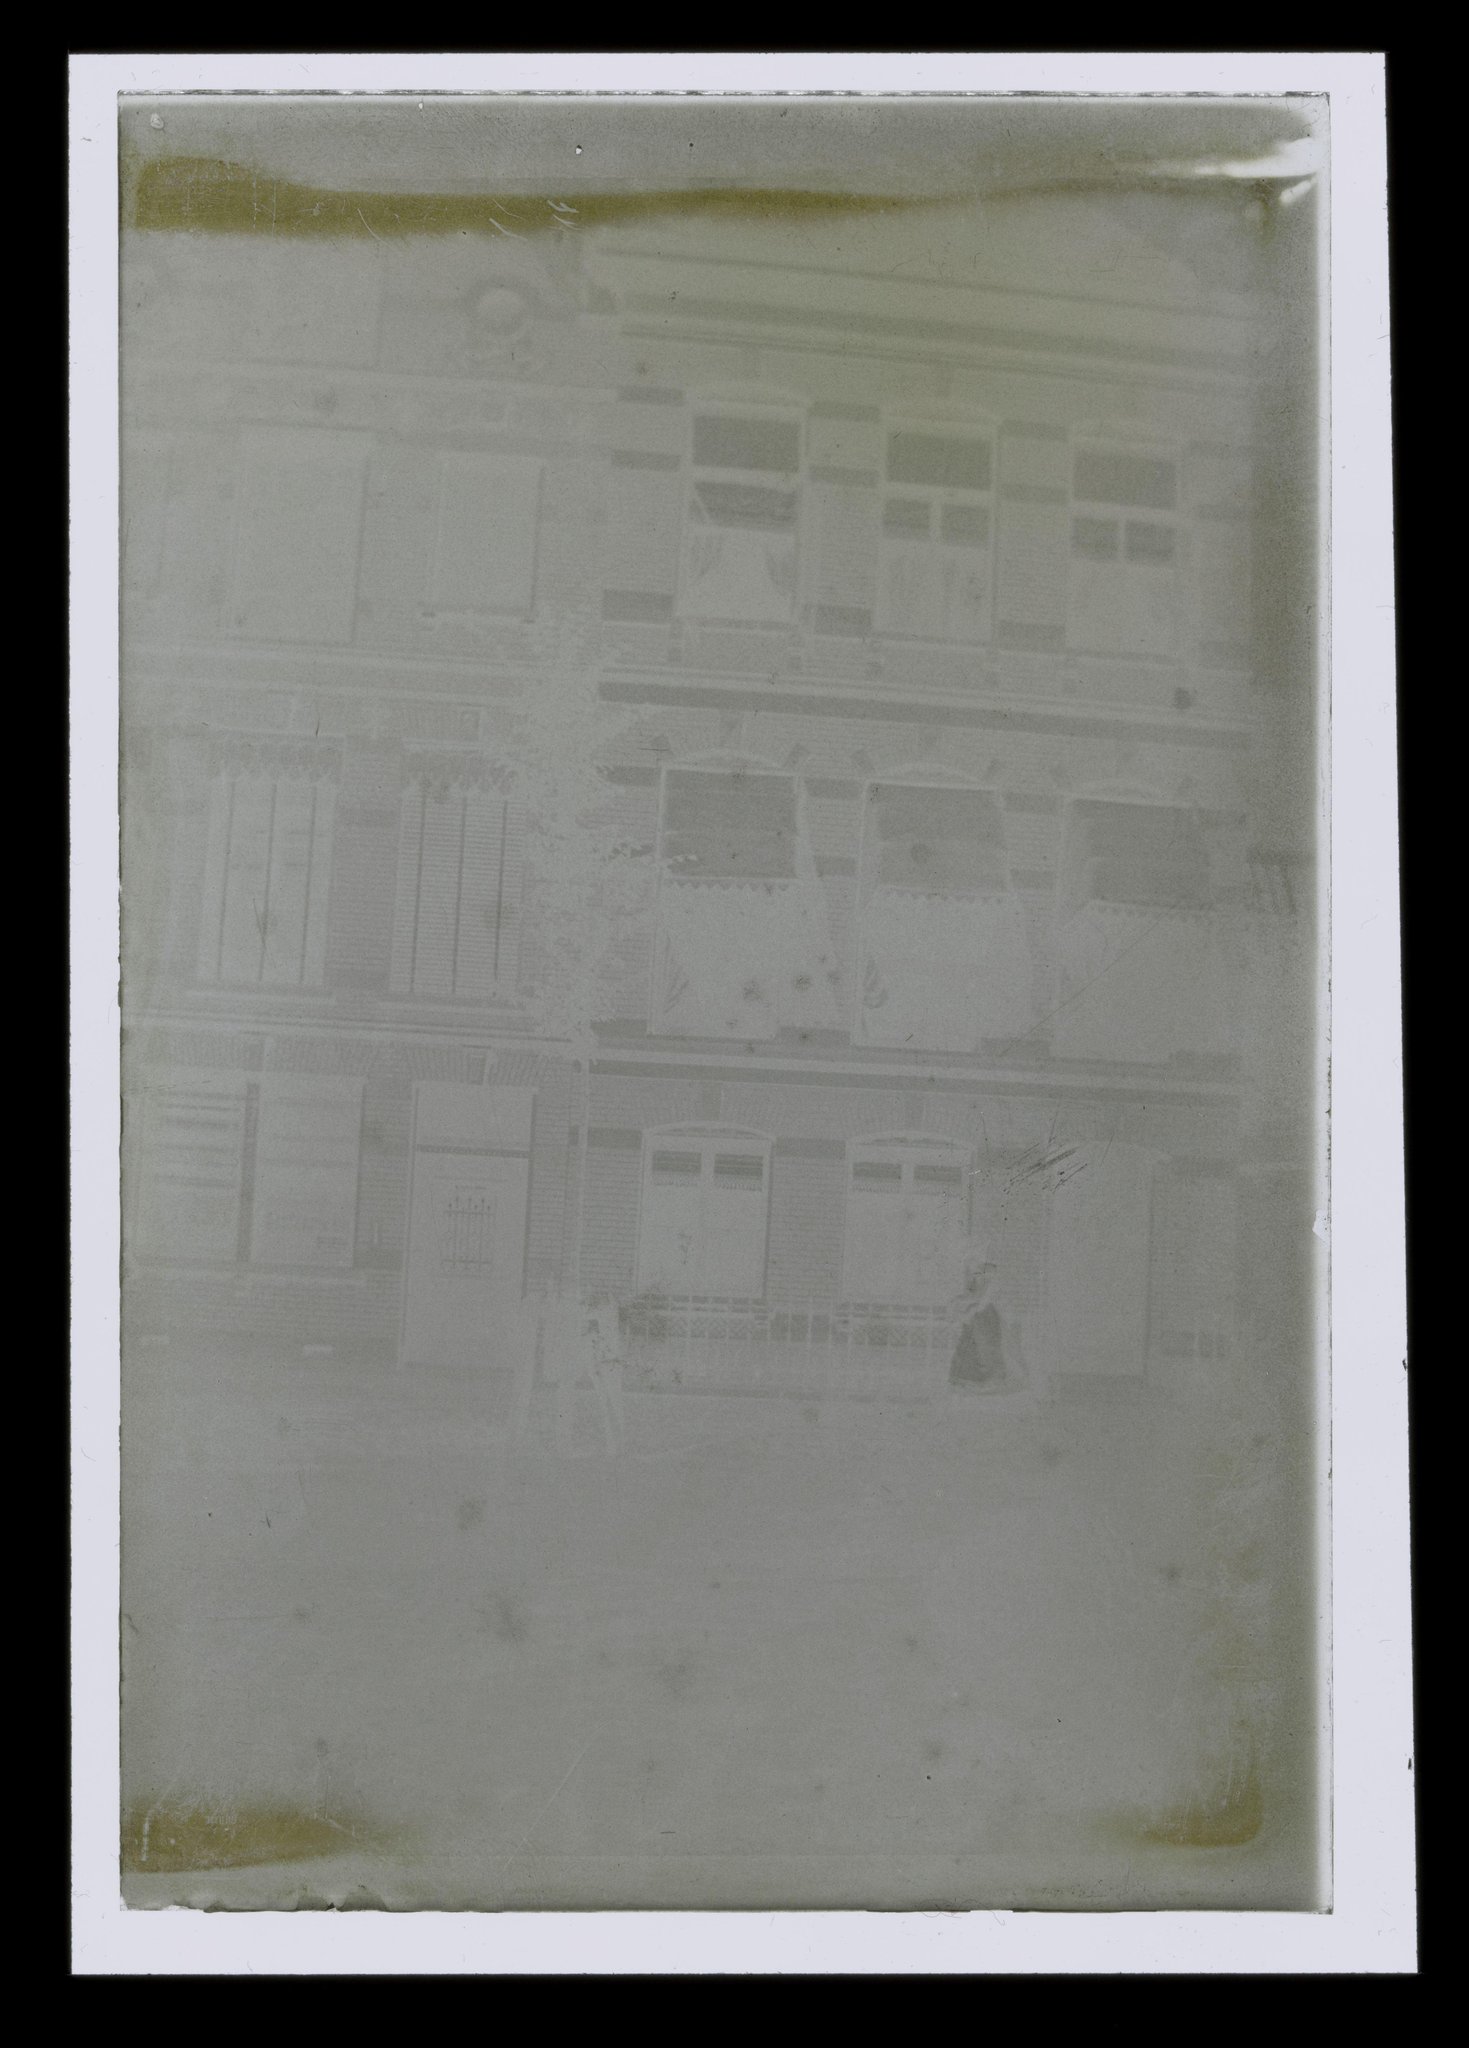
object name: glasnegatief, glasplaatnegatief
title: Gezicht op een gevel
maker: laurens lodewijk kleijn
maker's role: draughtsman, painter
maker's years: 1826-1909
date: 1865-1900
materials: glass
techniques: collodion process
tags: façade (of house or building)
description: Onderdeel van groep glasnegatieven uit de nalatenschap van de schilder Laurens Lodewijk Kleijn, stillevens, portretten, zelfportretten en kunstreproducties.